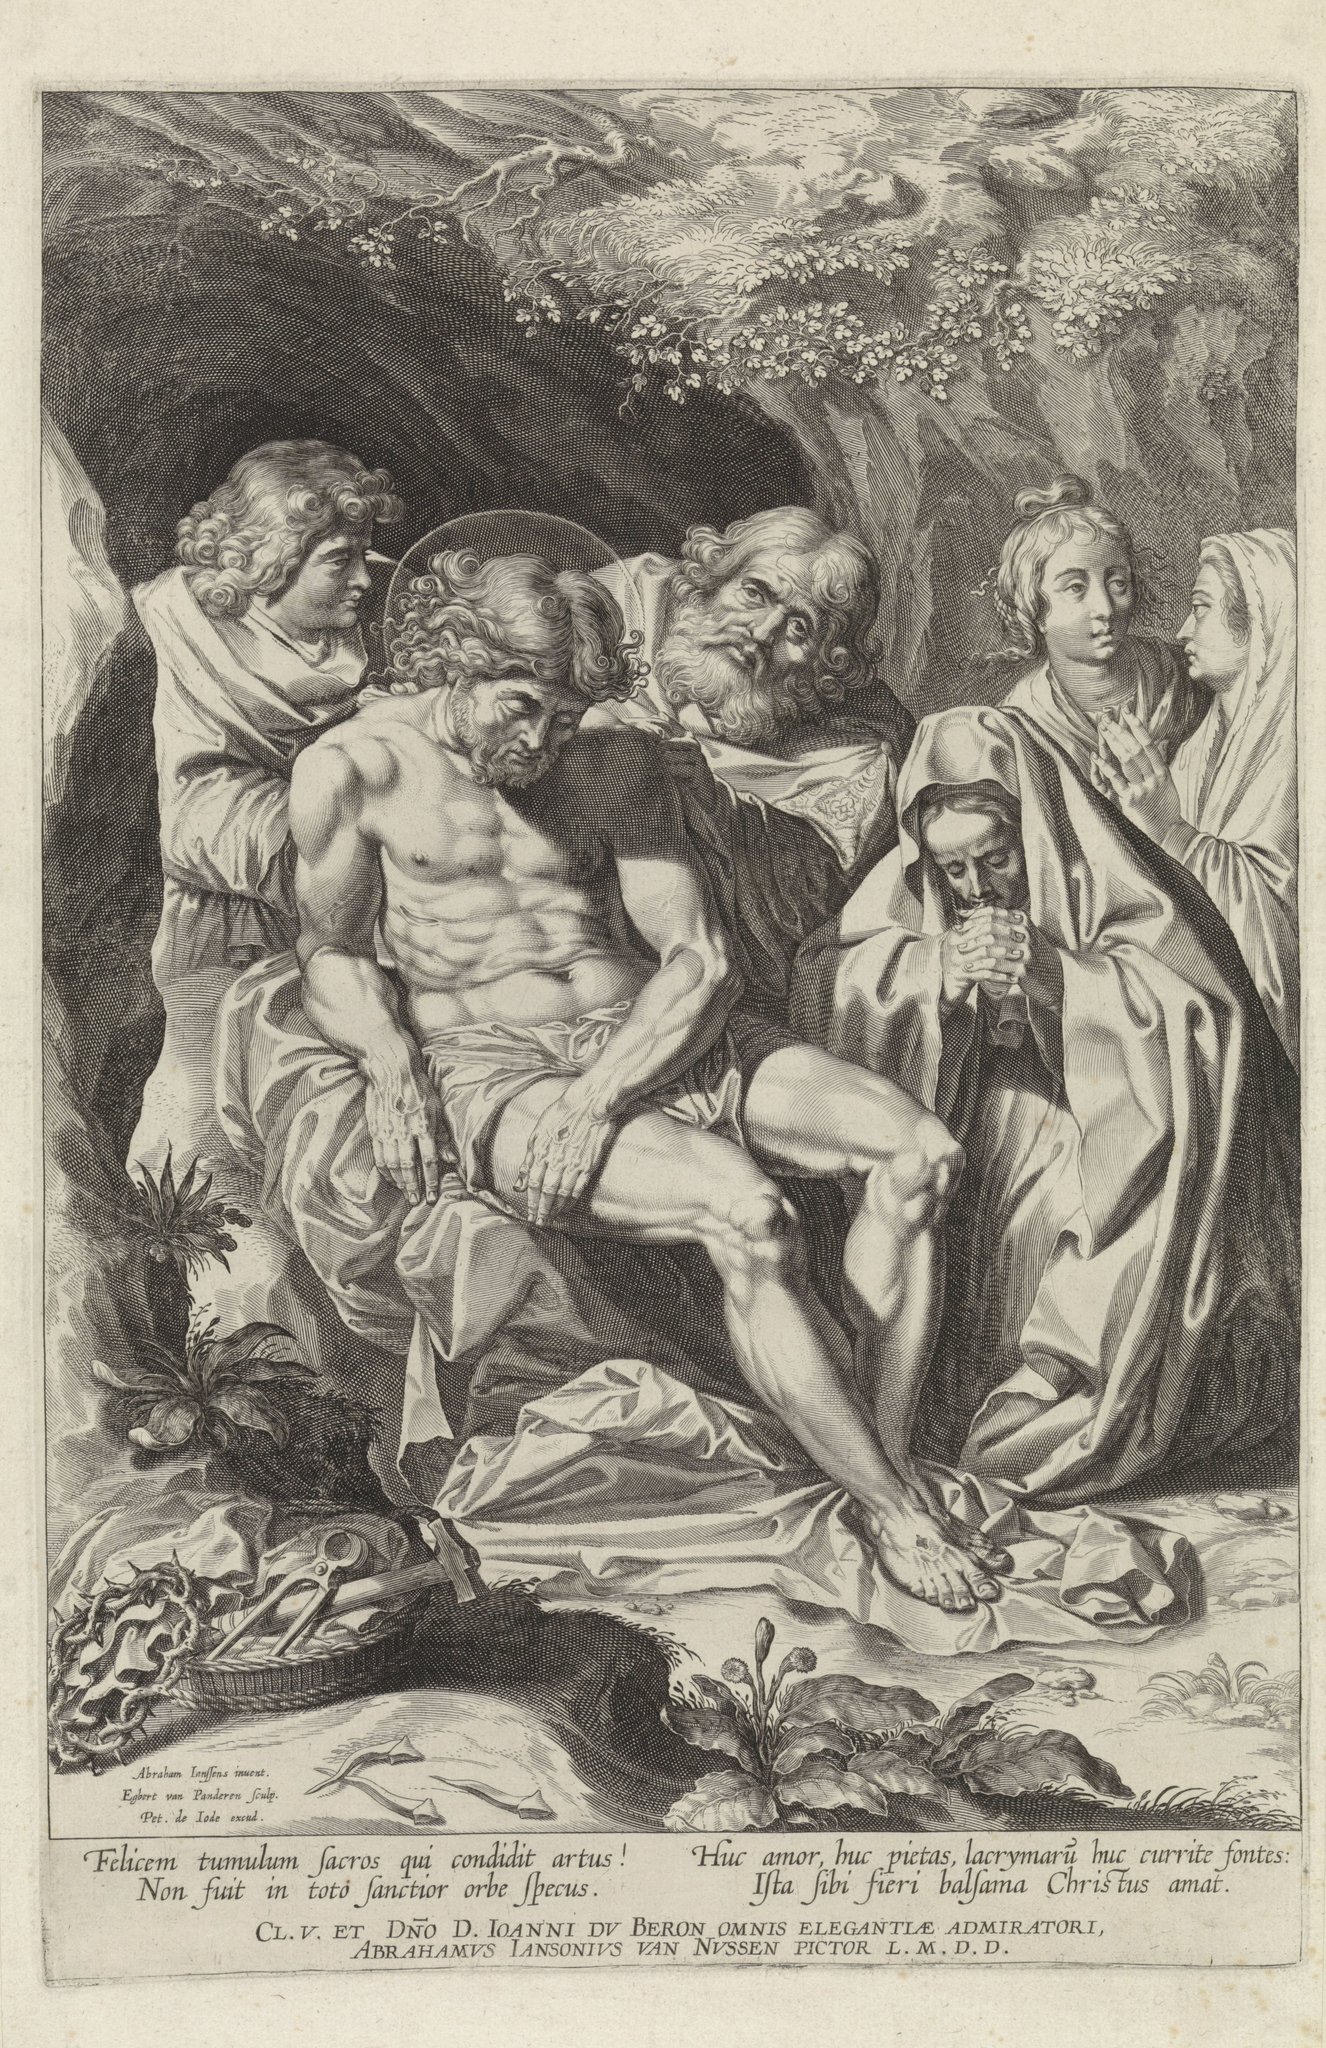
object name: print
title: Graflegging van Christus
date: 1590-1637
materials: paper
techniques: engraving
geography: antwerp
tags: christ's entombment (possibly by angels)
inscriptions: collector's mark: Lugt 240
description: Christus wordt door Jozef van Arimatea en Nikodemus in het graf gelegd. Aan de rechterkant een groep treurende vrouwen onder wie Maria en Maria Magdalena. Links op de voorgrond liggen passiewerktuigen in een mand. In de marge een vierregelig onderschrift, in twee kolommen, in het Latijn. Daaronder nog een tweeregelig onderschrift in het Latijn.